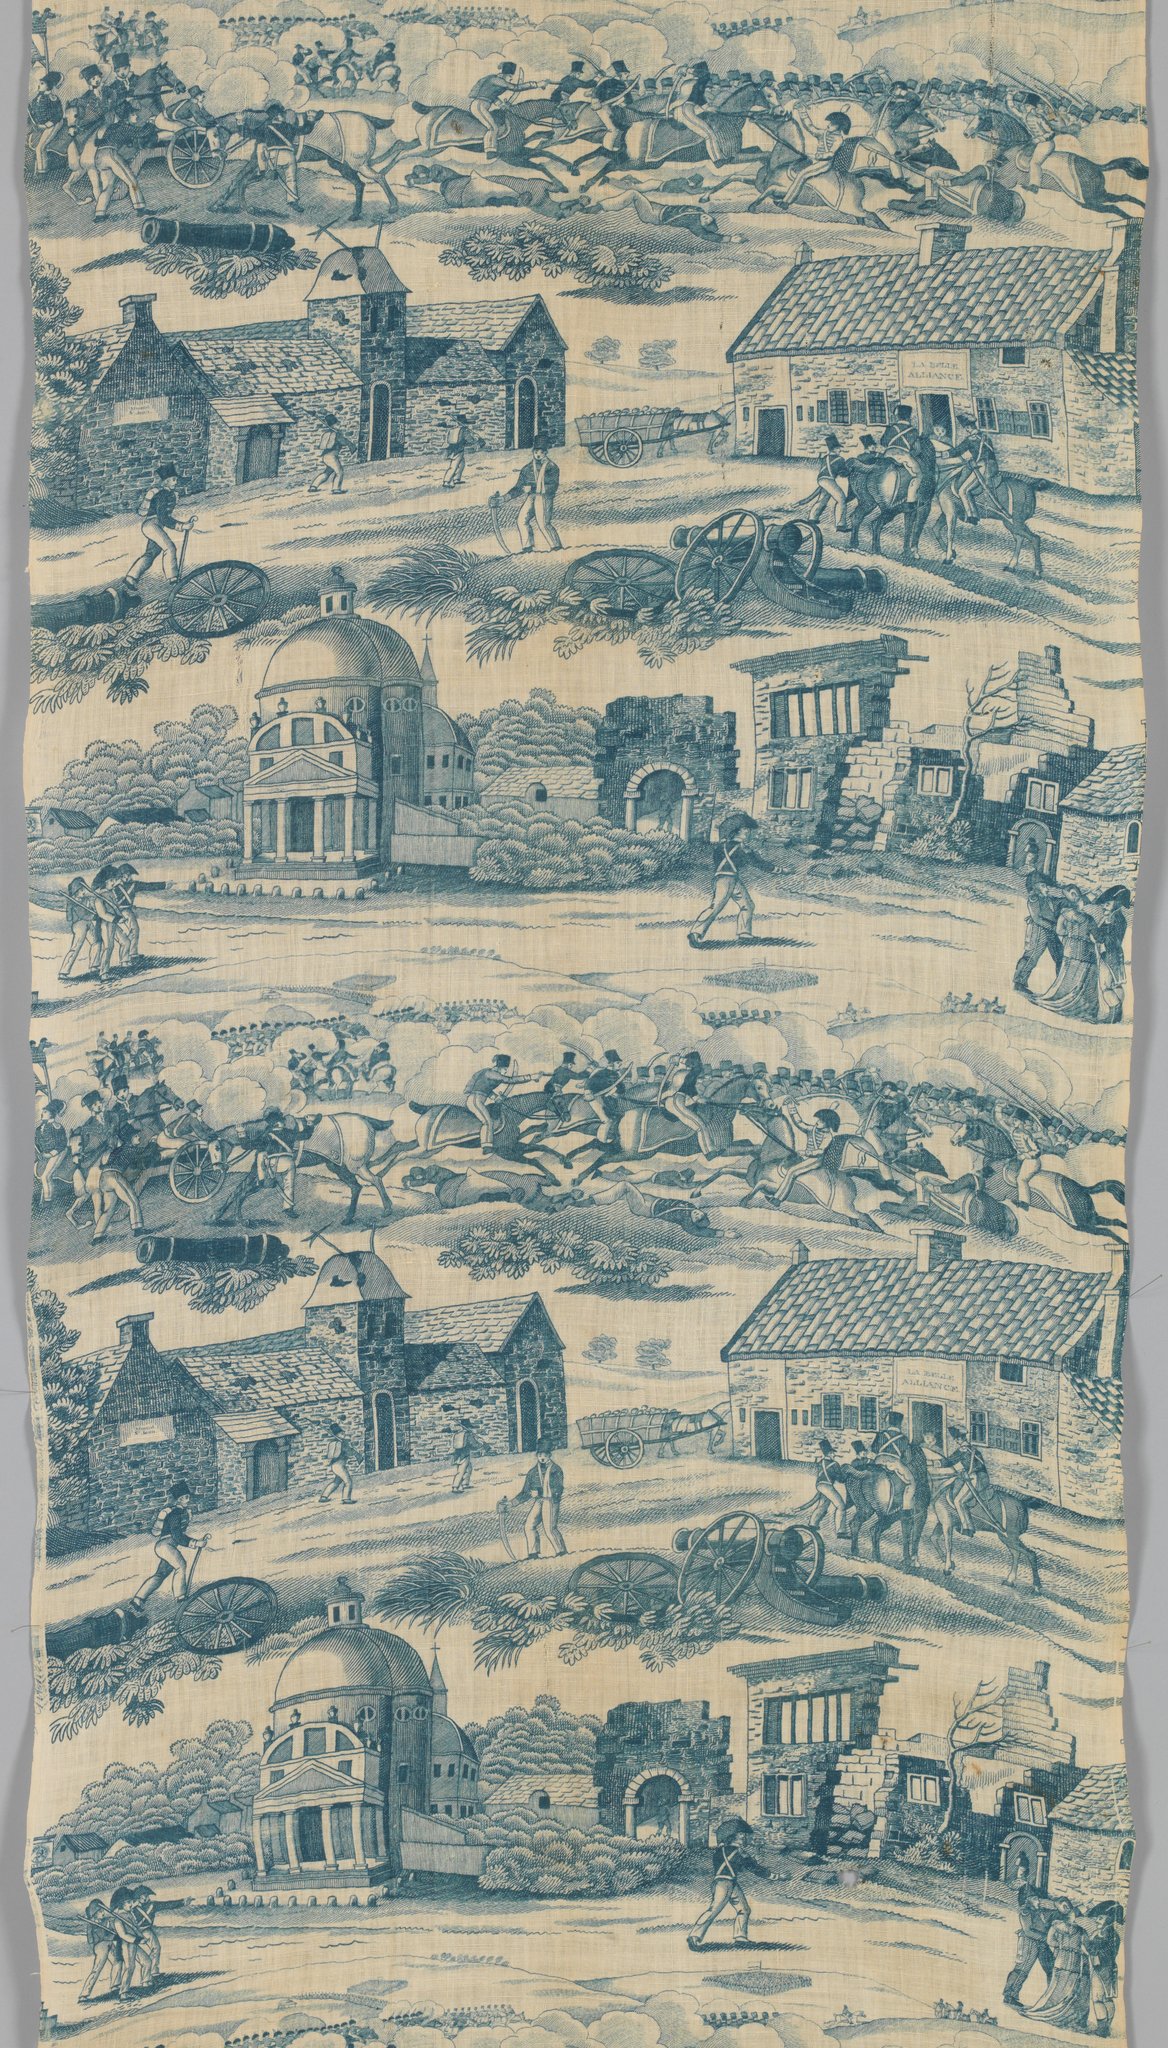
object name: piece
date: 1815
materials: cotton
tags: human figures,houses,horses